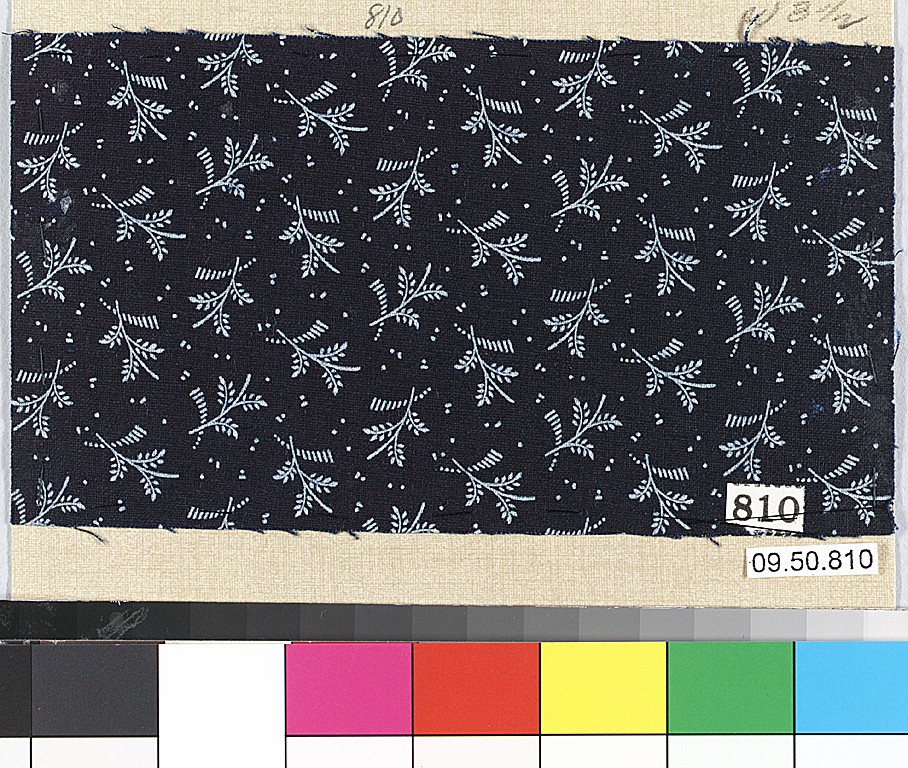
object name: piece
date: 1801-1900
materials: cotton